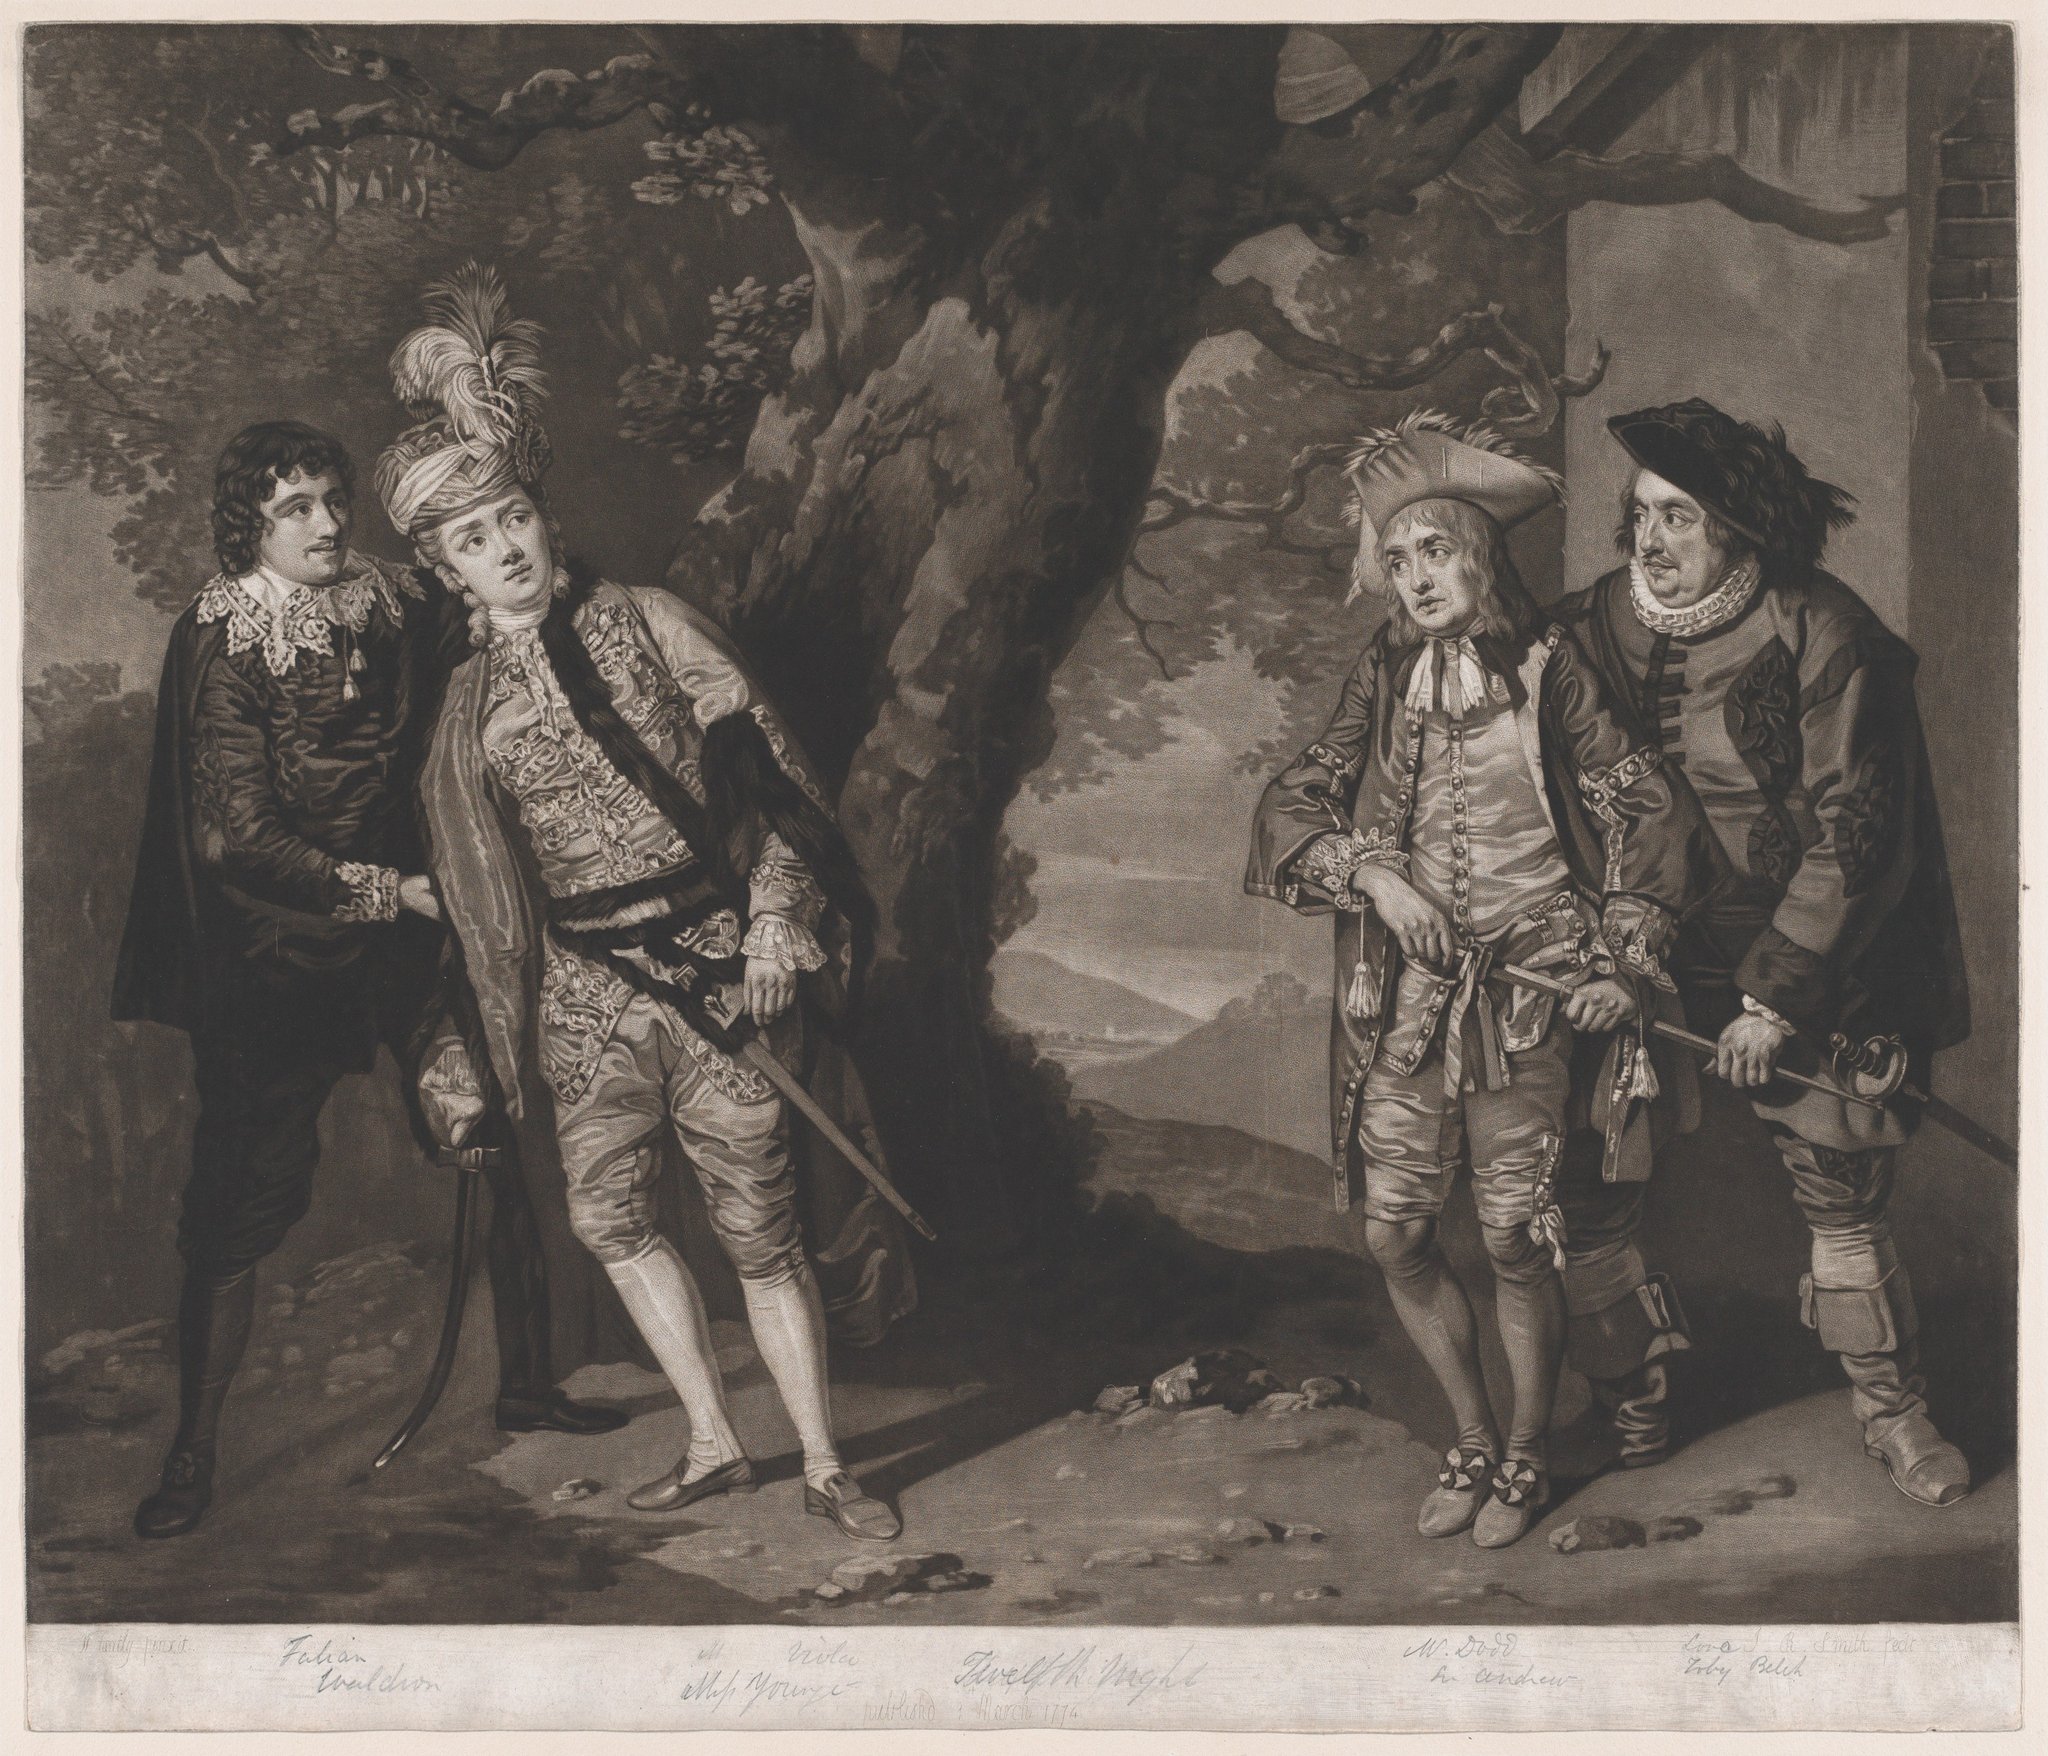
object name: print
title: Miss Younge, Mr. Dodd, Mr. Love, and Mr. Waldron, in the Characters of Viola, Sir Andrew Aguecheek, Sir Toby Belch, and Fabian (Shakespeare, Twelfth Night, Act 3, Scene 4)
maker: john raphael smith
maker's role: engraver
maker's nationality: british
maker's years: 1751-1812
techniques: mezzotint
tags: shakespeare,men,women,actors